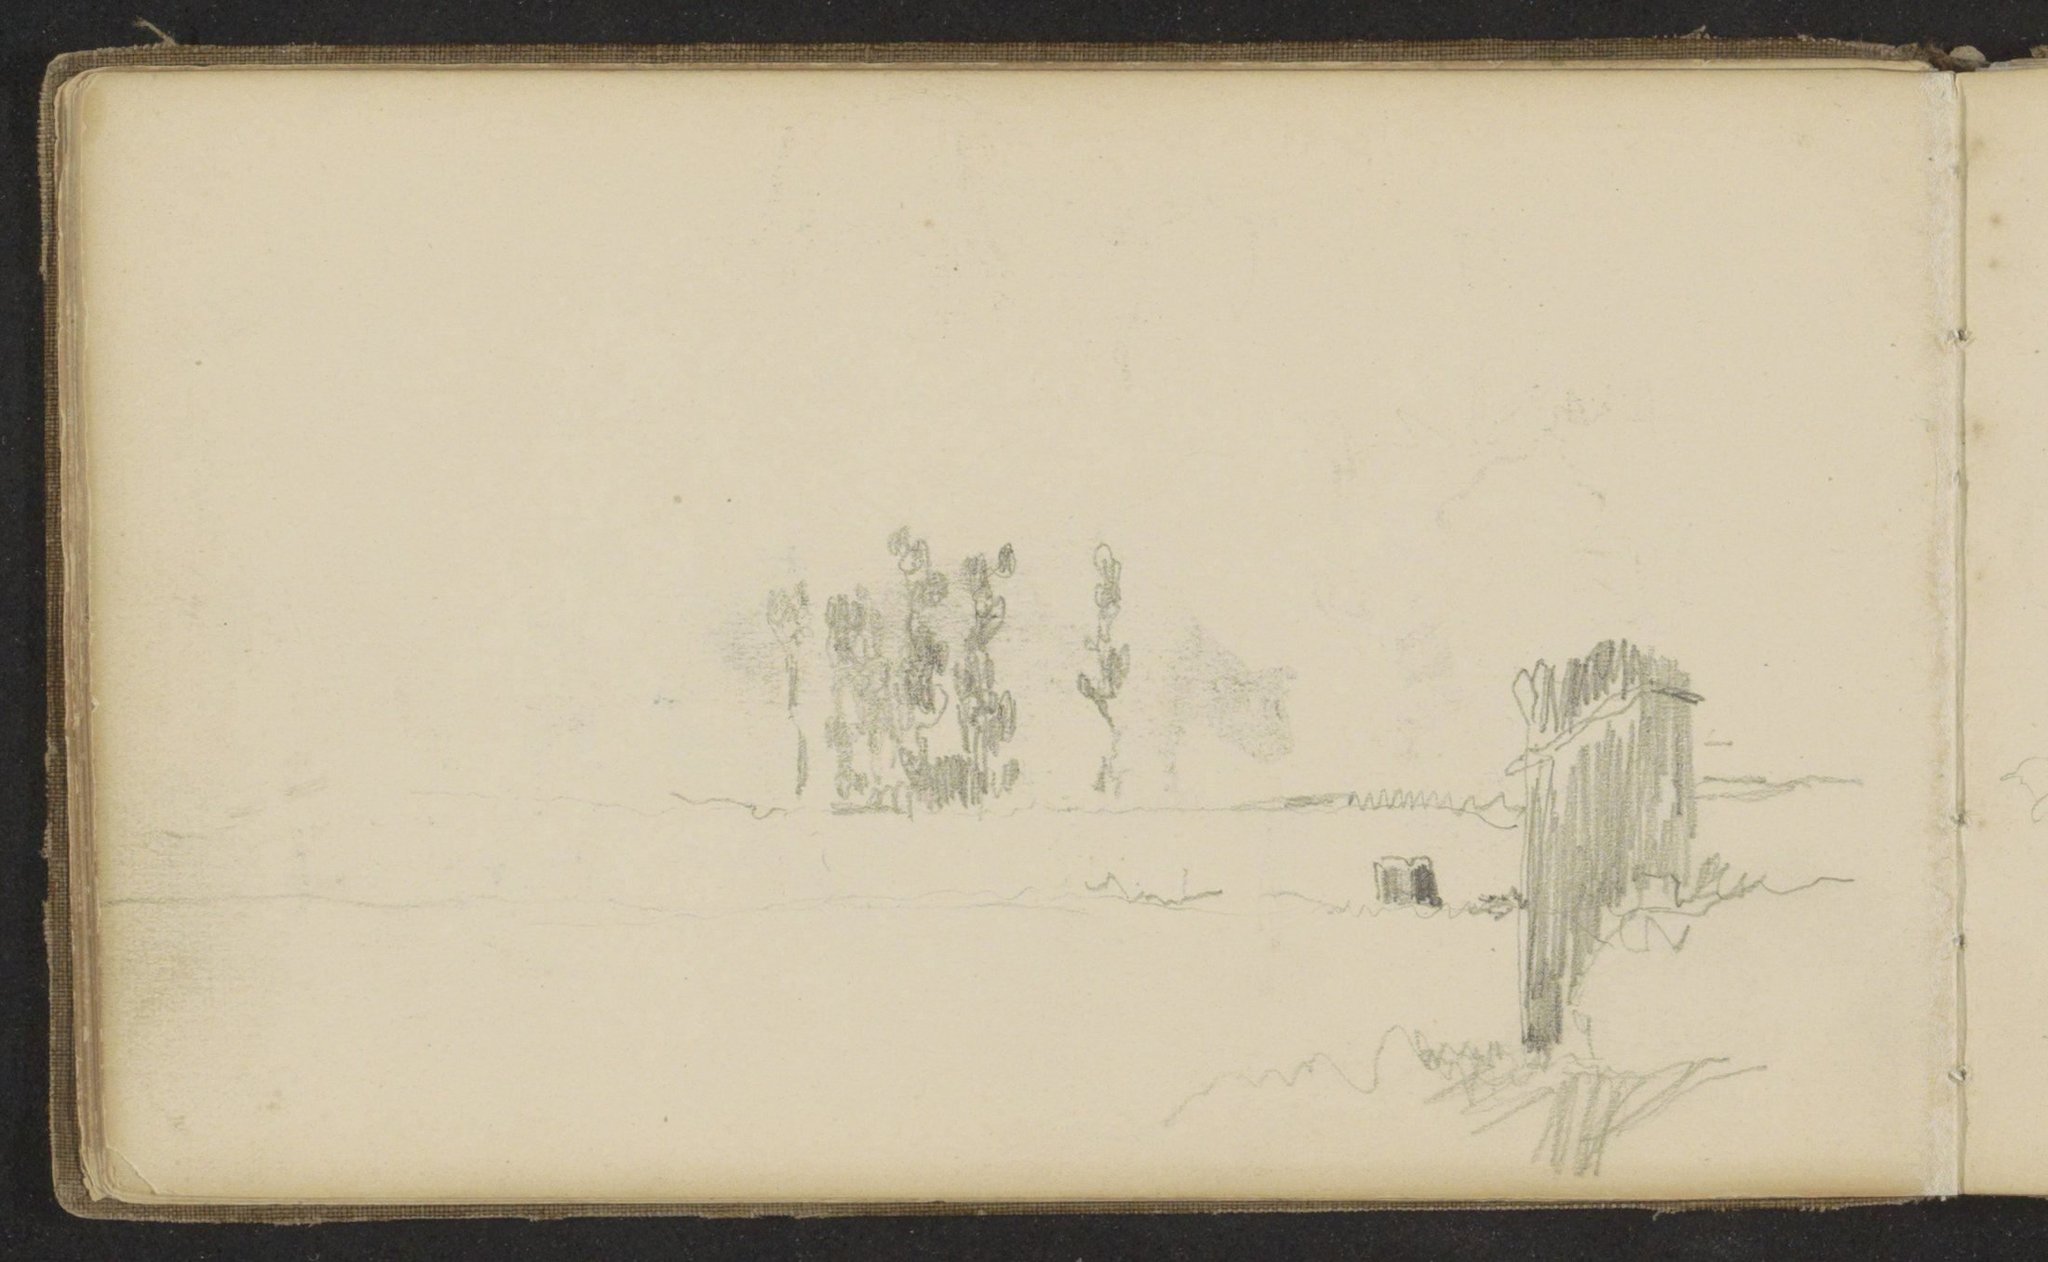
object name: sketchbook leaf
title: Weiland met bomengroep en hek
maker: johan hendrik weissenbruch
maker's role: draughtsman, painter, print maker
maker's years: 1824-1903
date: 1834-1903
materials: paper, pencil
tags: trees, fence, wall, paling, meadow, pasture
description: Blad 8 verso uit een schetsboek met 43 bladen.